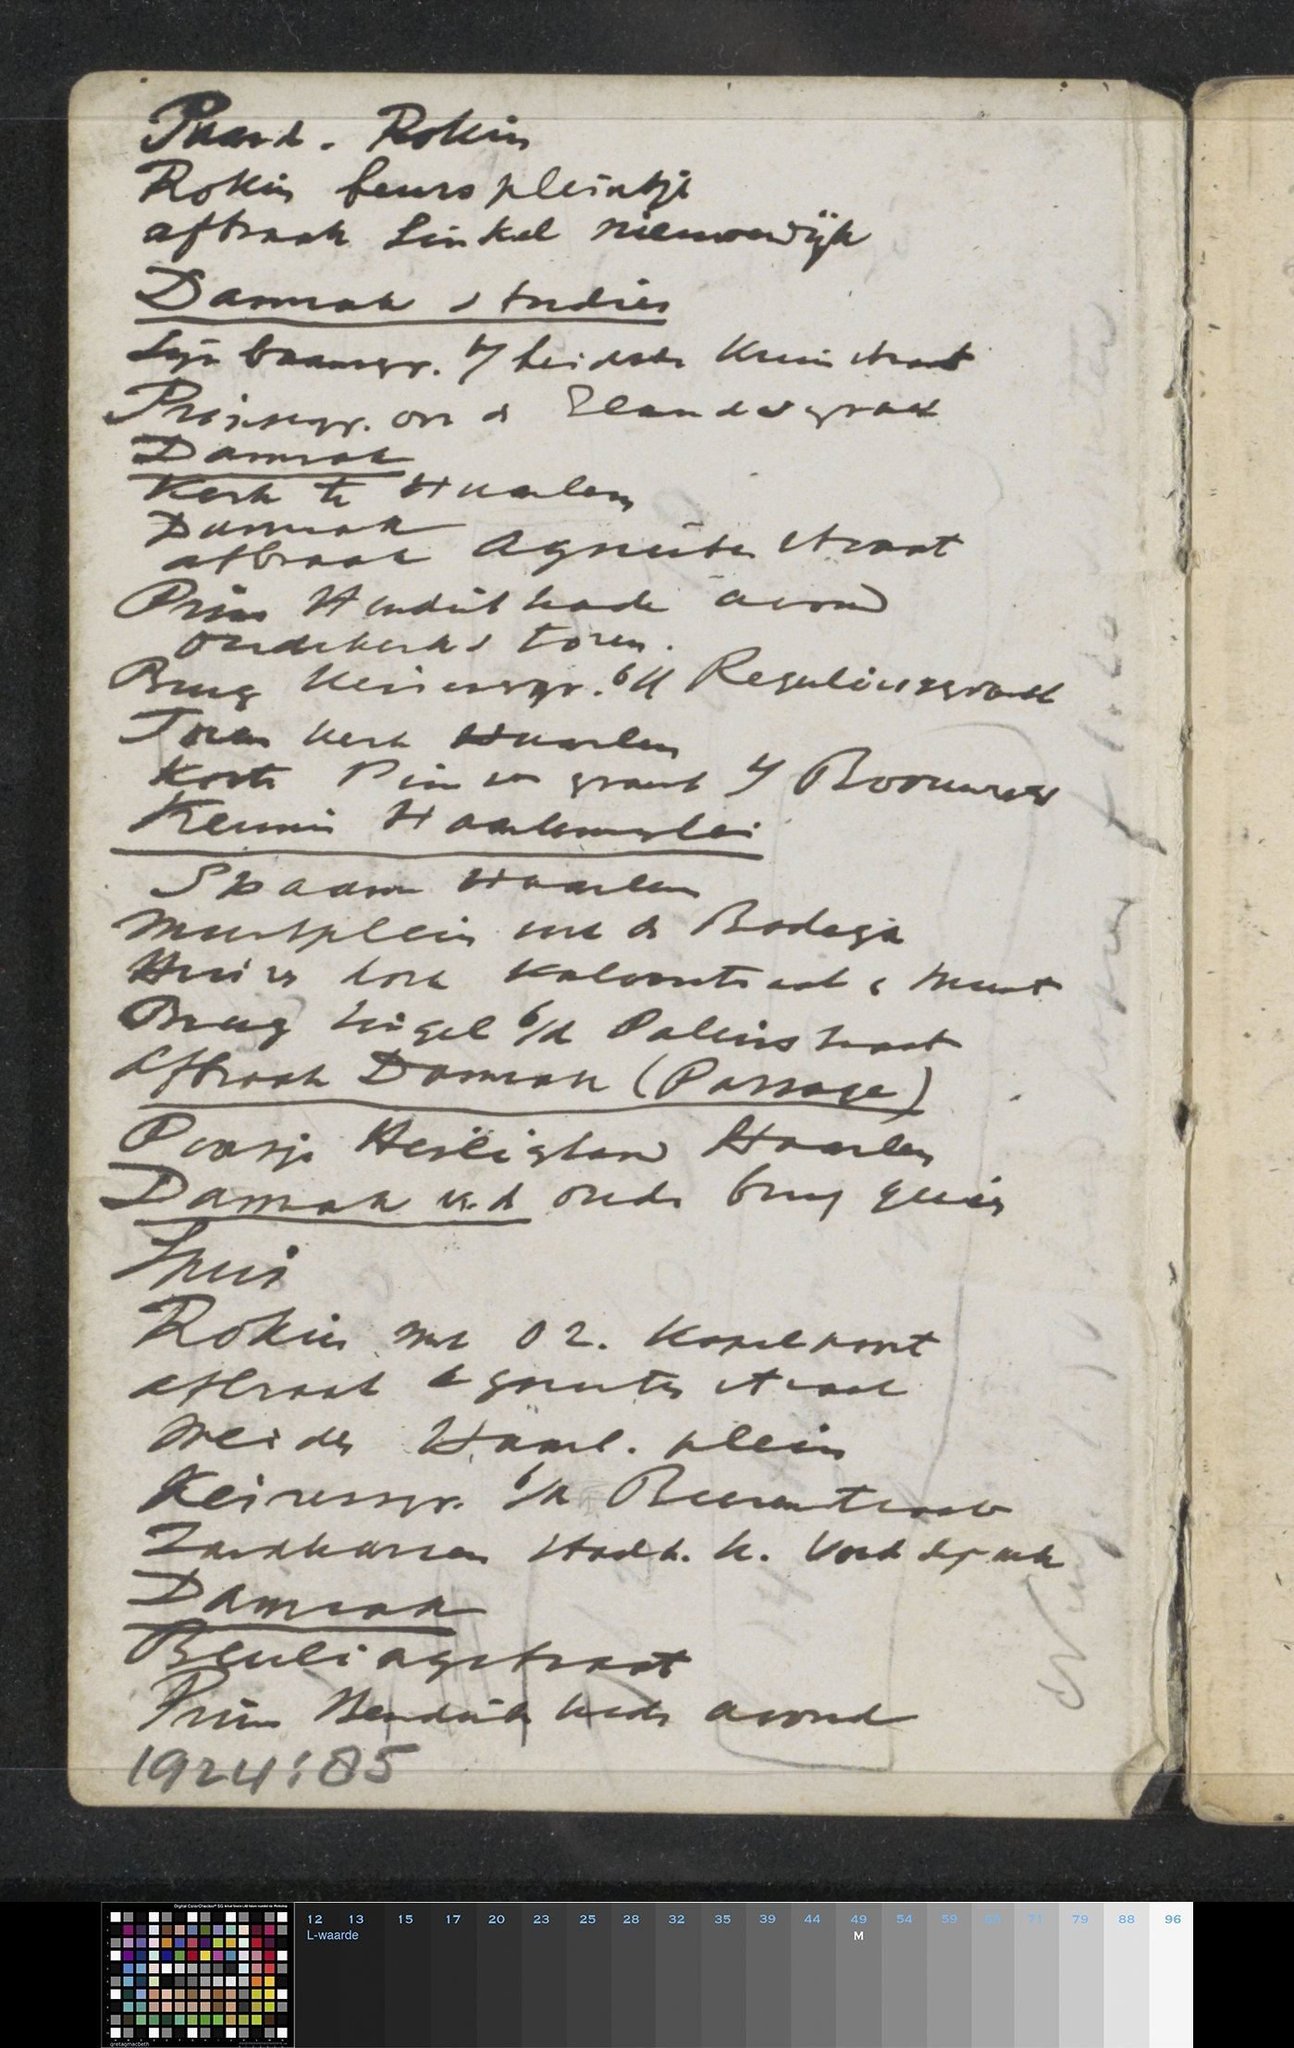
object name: sketchbook leaf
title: Annotaties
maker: george hendrik breitner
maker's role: draughtsman, painter, print maker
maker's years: 1857-1923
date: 1903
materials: ink, paper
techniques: writing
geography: amsterdam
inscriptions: annotation: ‘Paard. Rokin/ Rokin beurspleintje/ afbraak Sinkel Nieuwendijk/ Damrak studies/ Lijnbaansgr. b/ Leidsche Kruisstraat/ Prinsengr. [..] d Elandsgracht/ Damrak/ Kerk te Haarlem/ Damrak/ afbraak Agnietenstraat/ Prins Hendrikkade avond/ Oudekerks toren/ Brug Keizersgr. b/d Reguliersstraat/ Toren kerk Haarlem/ Korte Prinsengracht b/ Brouwersgr/ Kermis Haarlemmerplein/ Spaarne Haarlem/ Muntplein uit de Bodega/ Huizen hoek Kalverstraat & Munt/ Brug Singel b/d Paleisstraat/ Afbraak Damrak (Passage)/ Poortje Heiligland Haarlem/ Damrak v.d. oude brug gezien/ Spui/ Rokin met OZ. Kapelpoort/ afbraak Agnietenstraat/ Meiden Haarl. plein/ Keizersgr. b/d Beerenstraat/ Handkarren Stadh. k. Vondelpark/ Damrak/ Beulingstraat/ Prins Hendrik kade avond’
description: Annotaties. Pagina 1, voorste schutblad, uit een schetsboek met 46 bladen vervaardigd te Amsterdam en Haarlem.